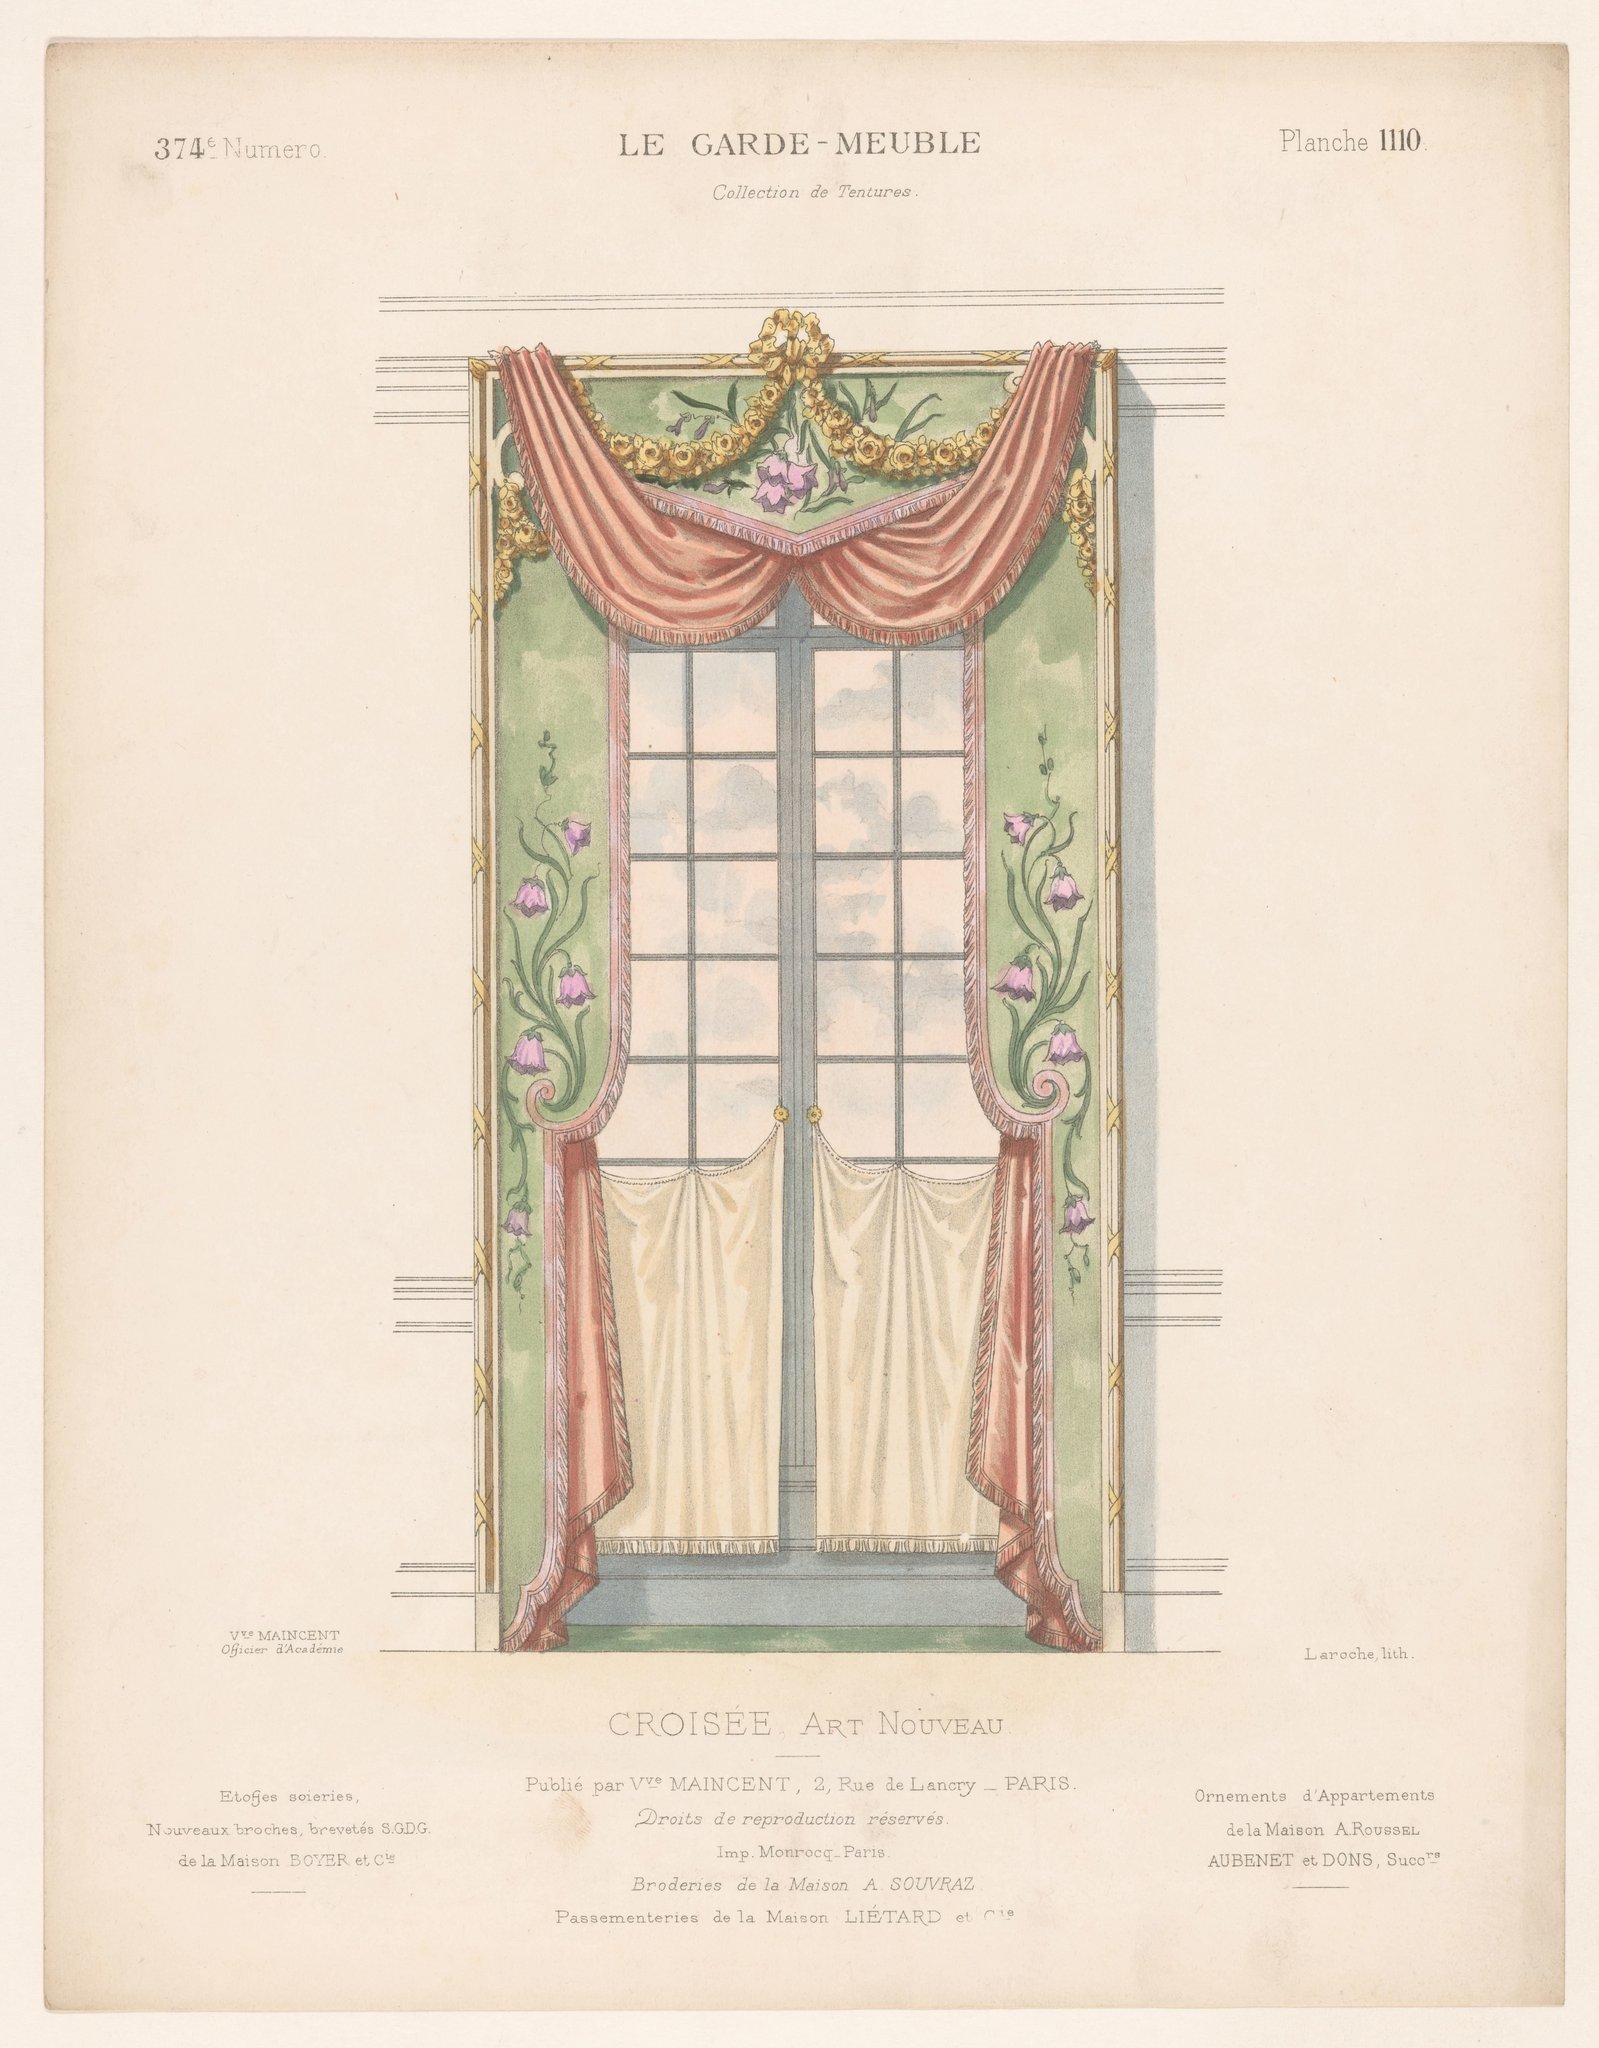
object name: print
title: Croisée, Art Nouveau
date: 1895-1910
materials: paper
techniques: hand coloring, lithograph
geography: paris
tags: window, hangings and drapery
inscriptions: : ‘Droits de reproduction réservés.’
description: Kruisvenster met gedrapeerde gordijnen in de art-nouveaustijl. Prent uit 374e Livraison.